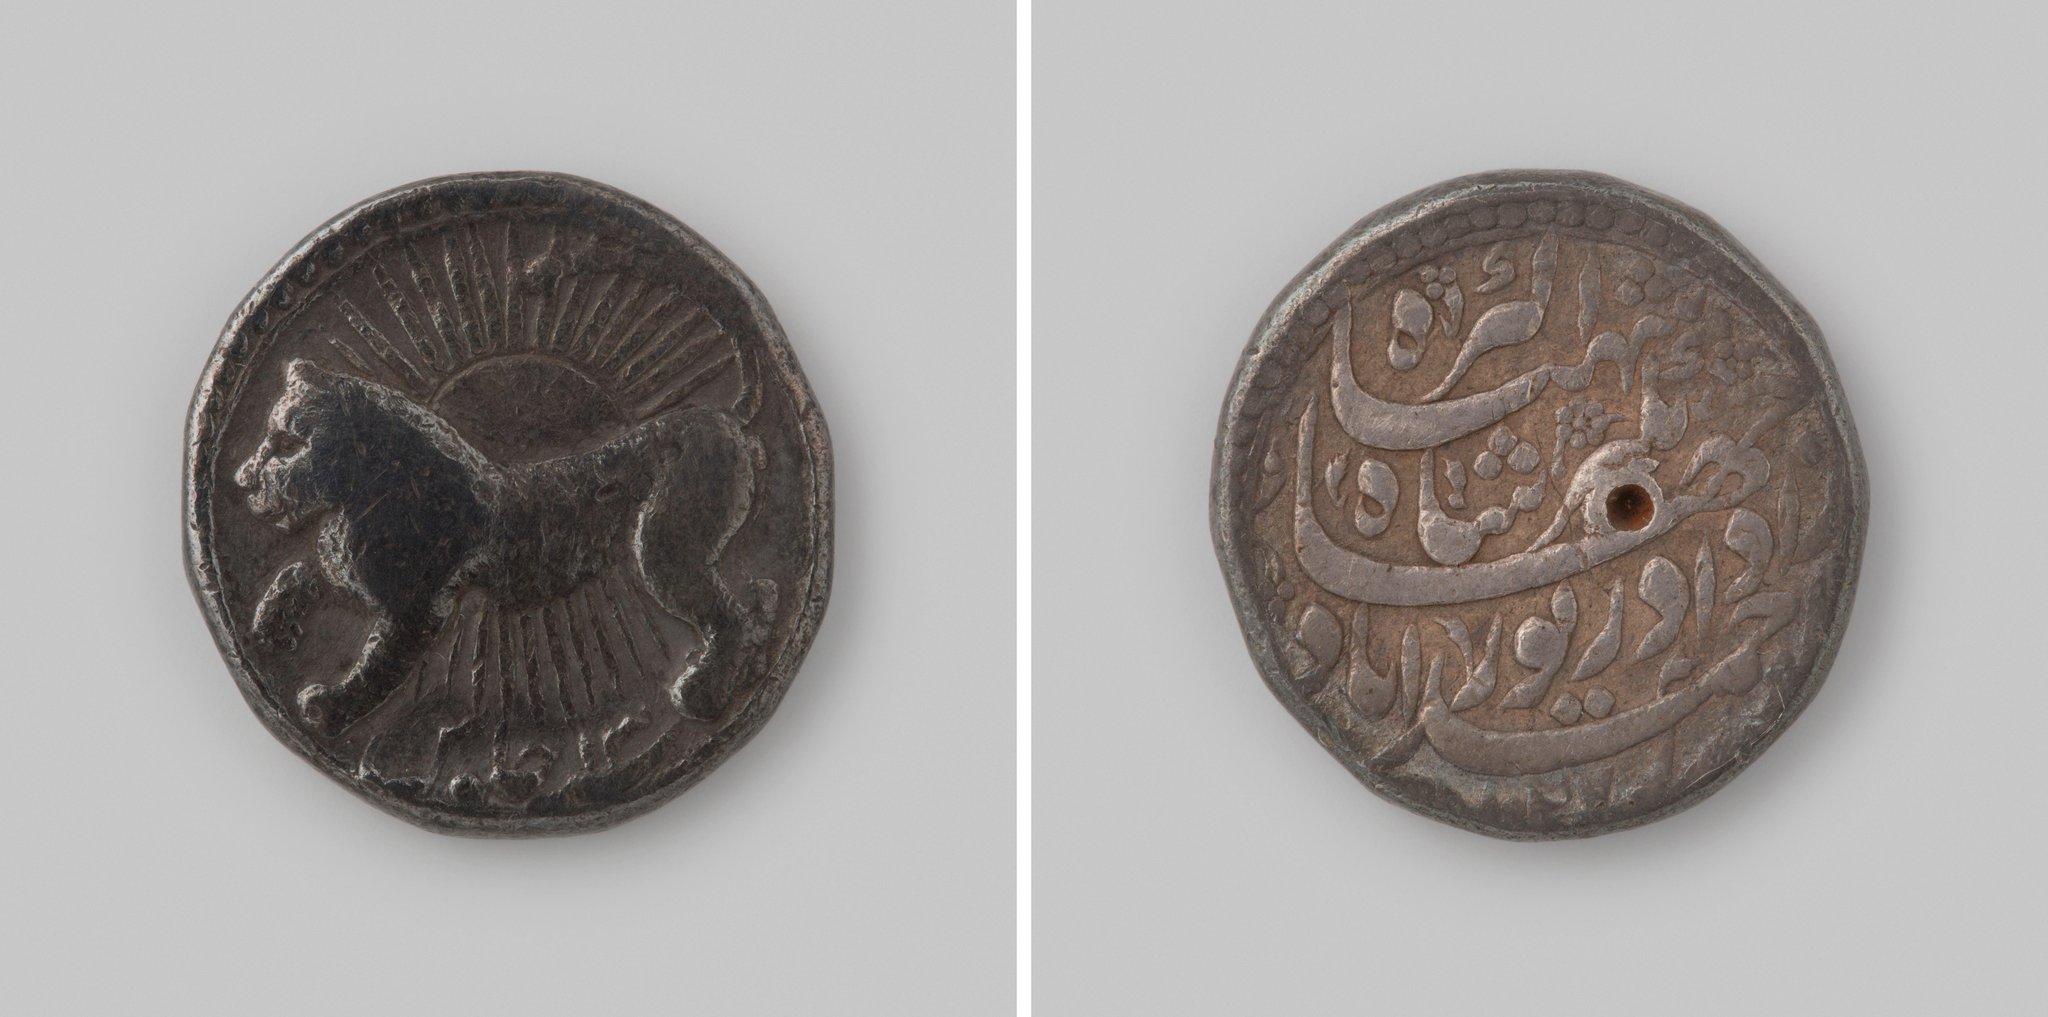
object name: coin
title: Roepie uit India van Jahangir, 1027 [=1618], geslagen te Ahmed-abad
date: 1618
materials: silver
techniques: striking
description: Zilveren munt. Voorzijde: leeuw naar links, waarachter opkomende stralende zon. Onder de leeuw eenregelig opschrift in Arabische lettertekens. Keerzijde: in Arabische lettertekens in vier regels opschrift. Op onderste regels aanduiding muntplaats: Ahmed-abad en jaartal: 1027.